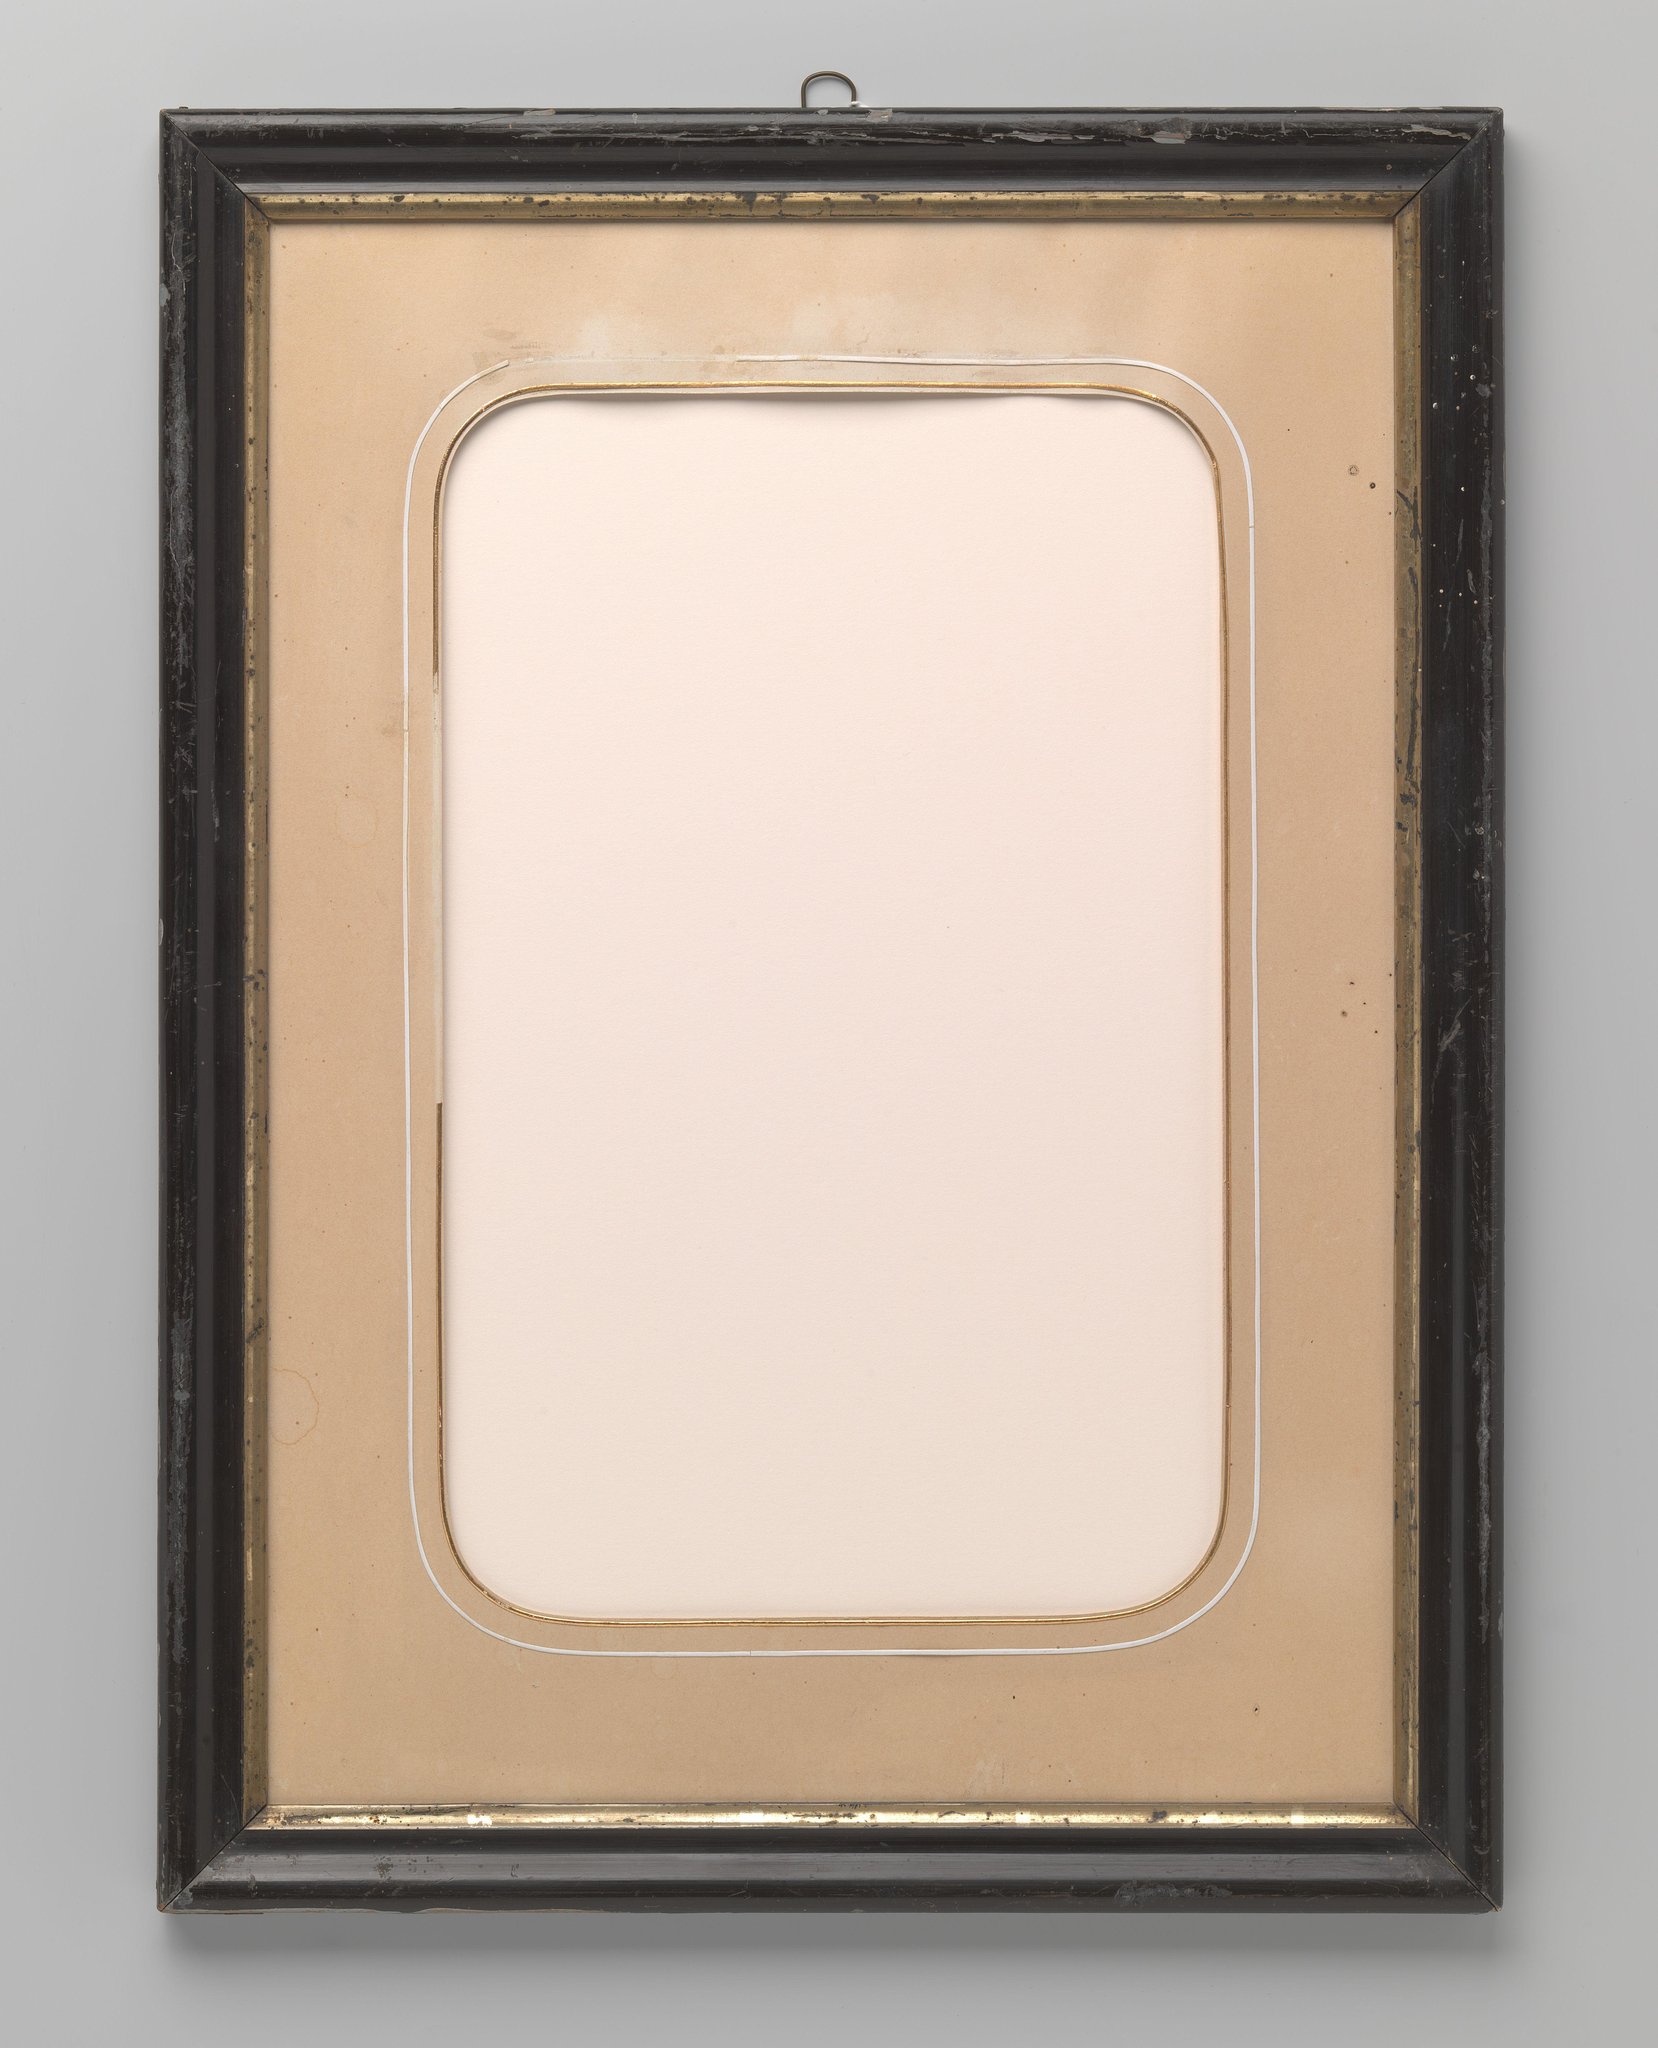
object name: frame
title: Picture Frame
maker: Anonymous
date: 1850-1899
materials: cardboard, paper, wood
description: Lijst behorende bij geborduurd portret Bismarck naar foto, van Werbeschule Grünberg.